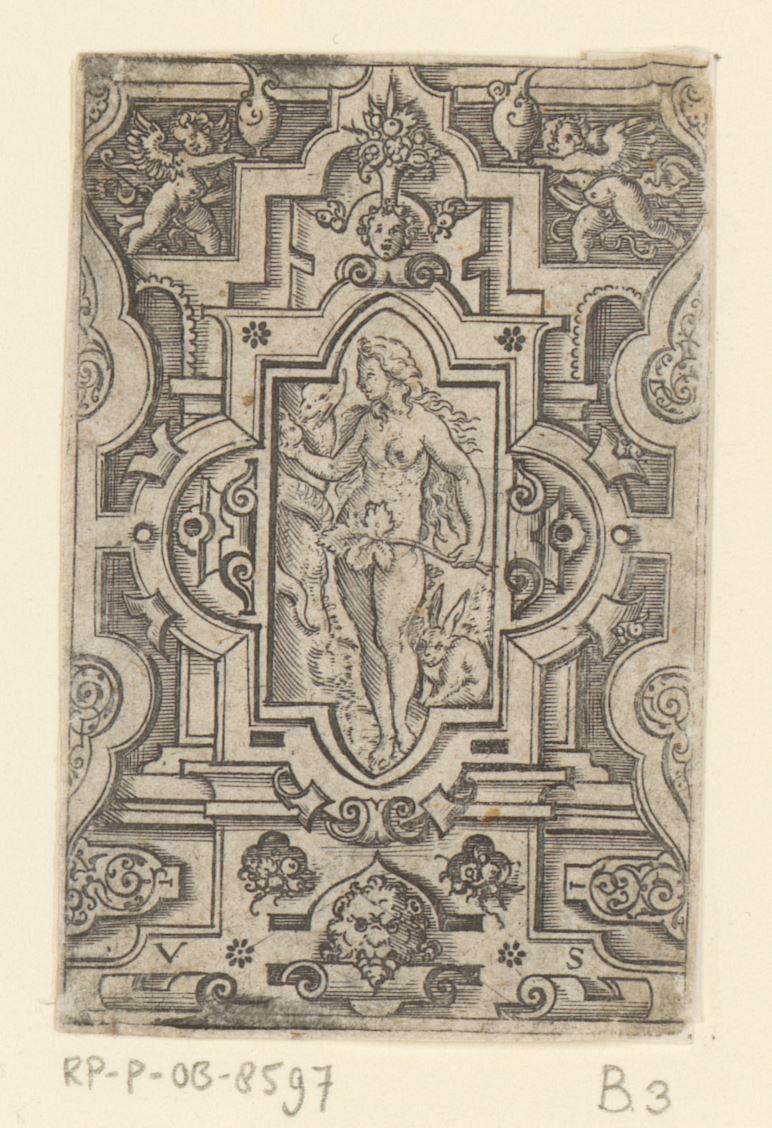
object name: print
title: Eva in rolwerk omlijsting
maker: virgilius solis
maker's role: draughtsman, print maker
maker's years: 1514-1562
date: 1524-1562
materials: paper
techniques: engraving, etching, intaglio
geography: nuremberg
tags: scrollwork, strapwork ~ ornament, eve (not in biblical context)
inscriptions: number: ‘126’, collector's mark: Lugt 2228